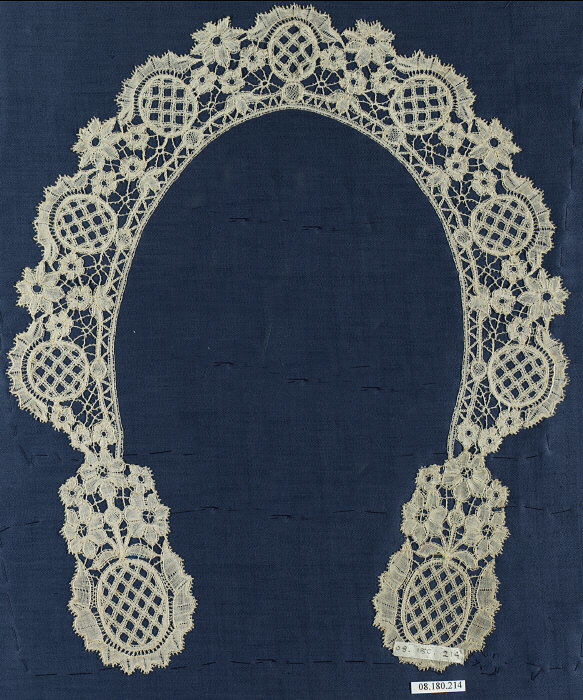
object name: collar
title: Collar lace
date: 1801-1900